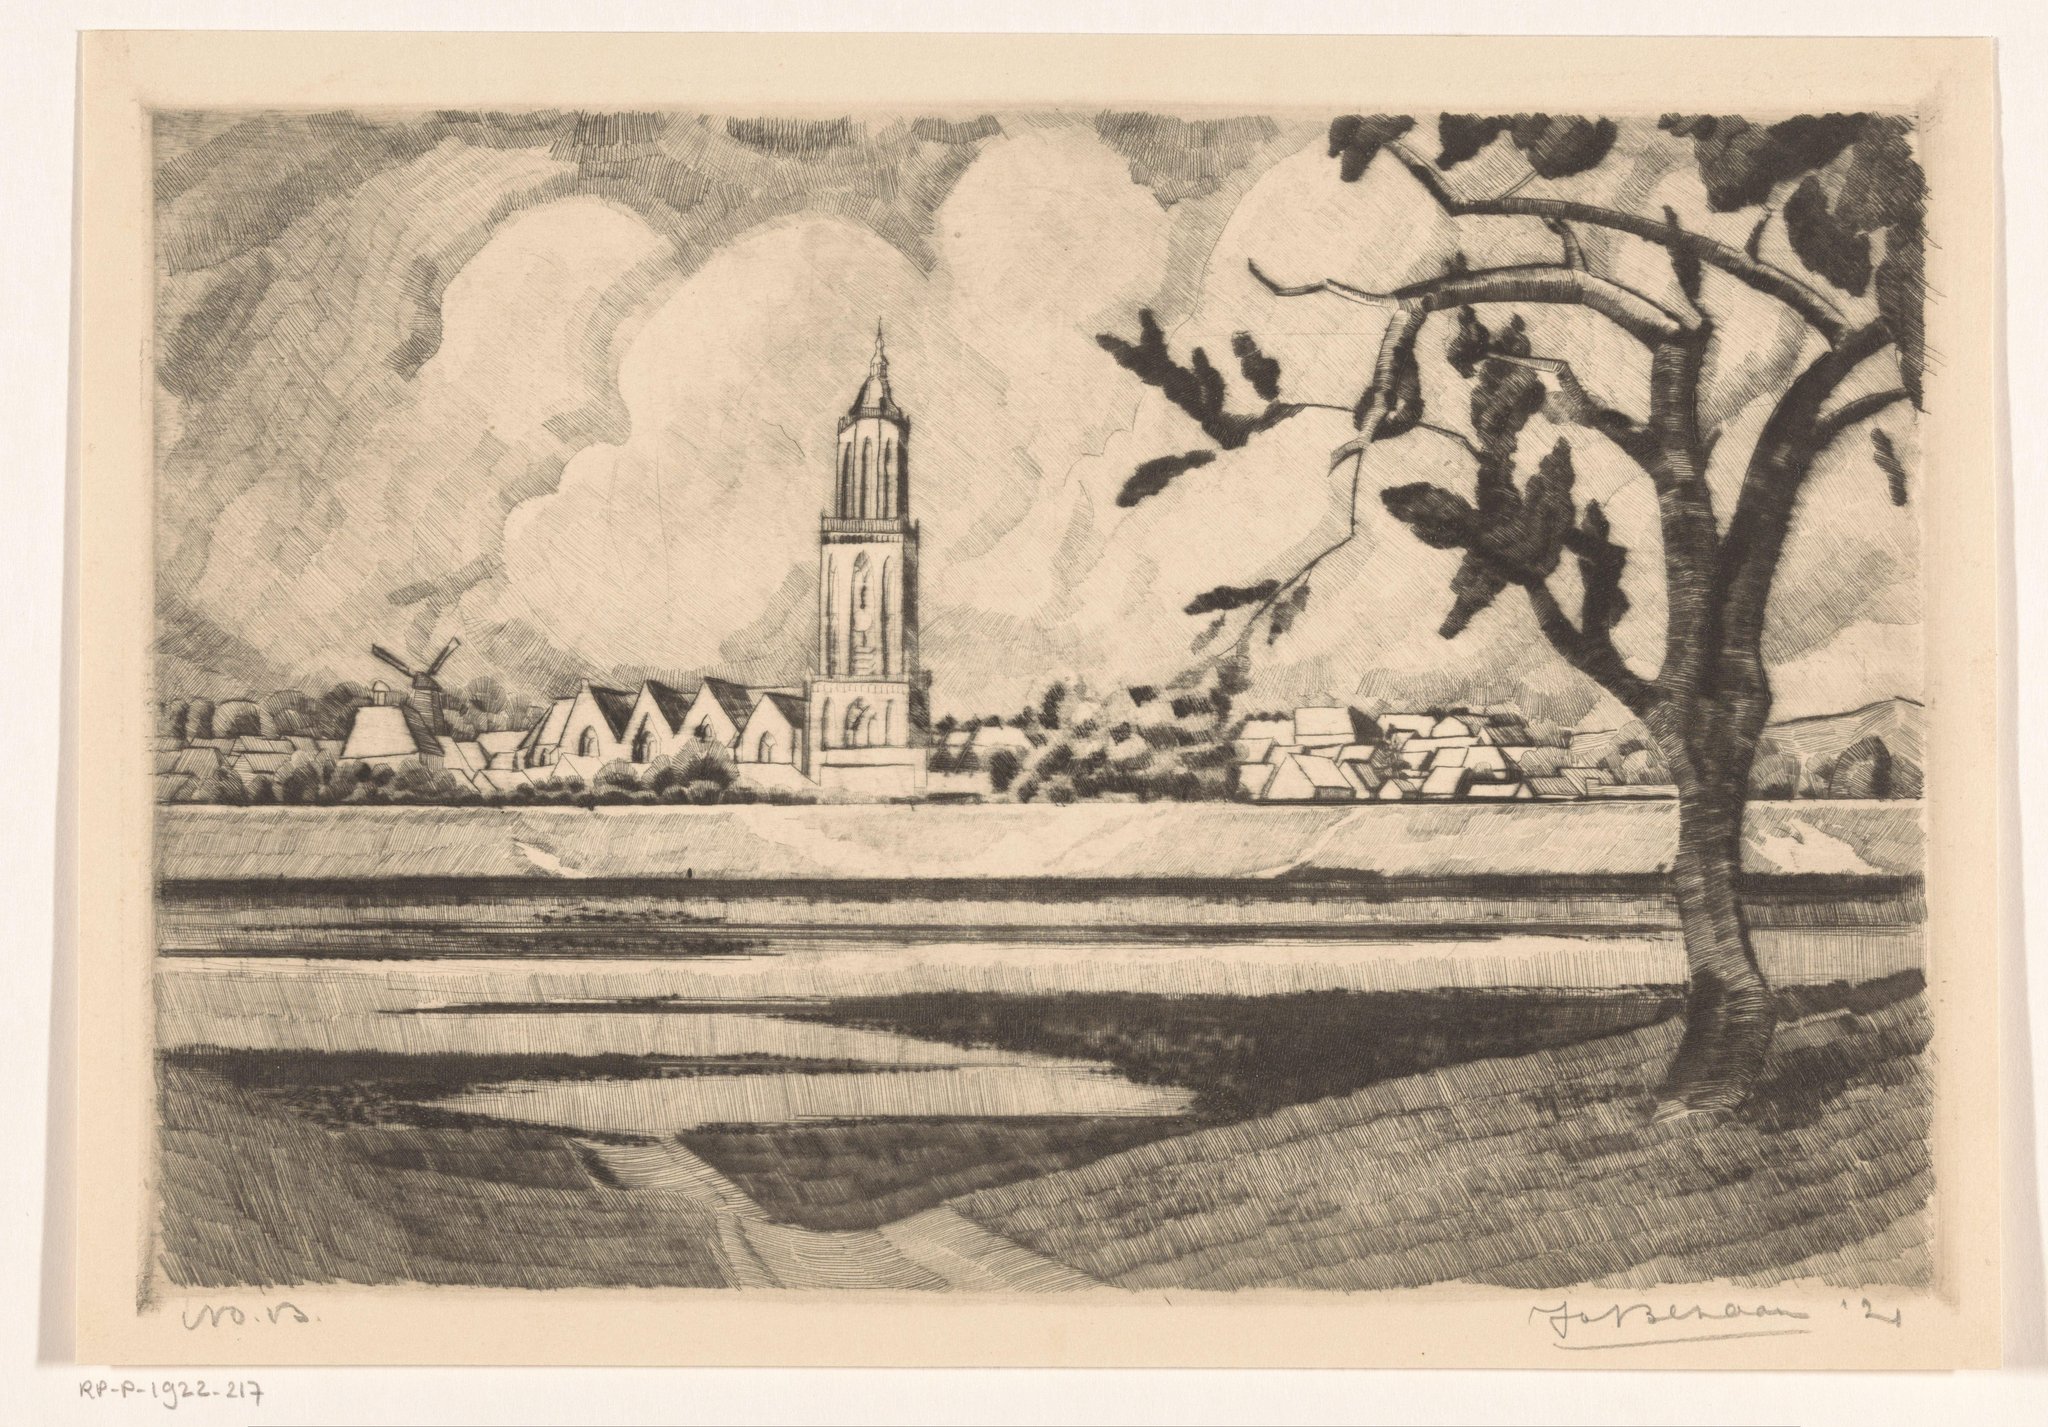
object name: print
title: Rhenen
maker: jo bezaan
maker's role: draughtsman, print maker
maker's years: 1894-1952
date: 1921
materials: paper, ink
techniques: drypoint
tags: village, rhenen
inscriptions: number: ‘No. 13’, signature and date: ‘Jo Bezaan '21’, collector's mark: Lugt 2228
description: Gezicht op Rhenen met op de voorgrond de Rijn en links van het midden de Cuneratoren.